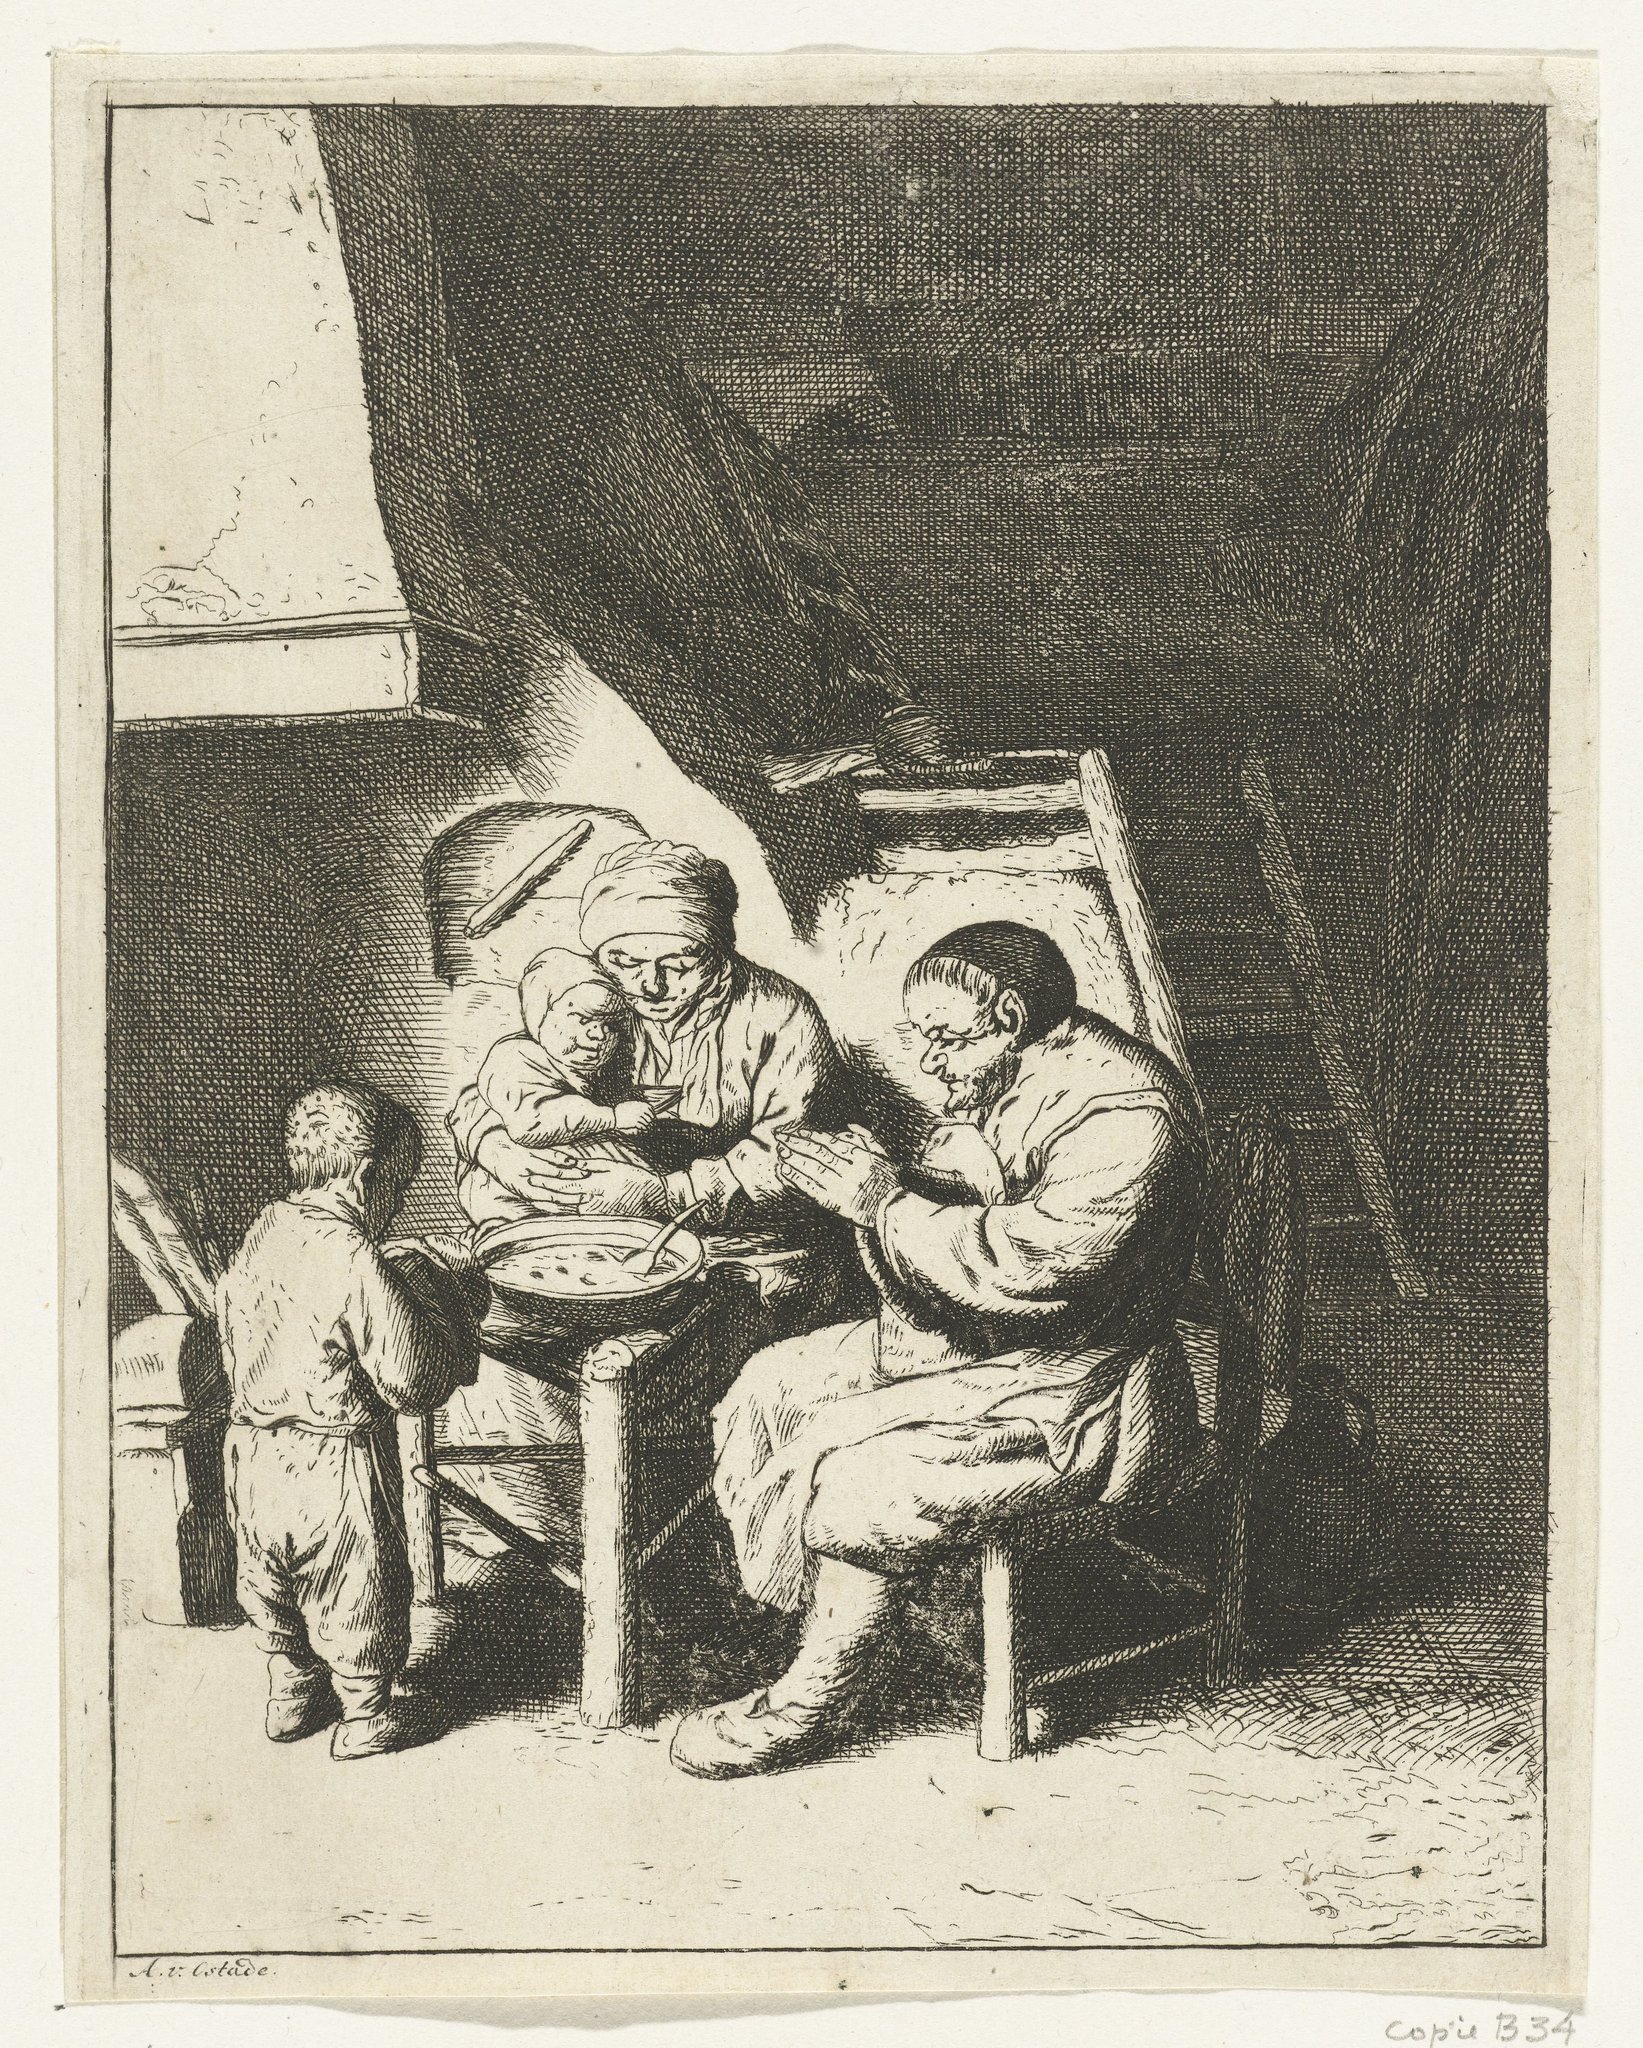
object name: print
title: Gezin aan tafel voor de maaltijd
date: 1653-1745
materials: paper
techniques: etching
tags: family life, prayer at table, saying grace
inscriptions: collector's mark: Lugt 240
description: Kopie naar prent van Adriaen van Ostade met voorstelling spiegelverkeerd weergegeven.